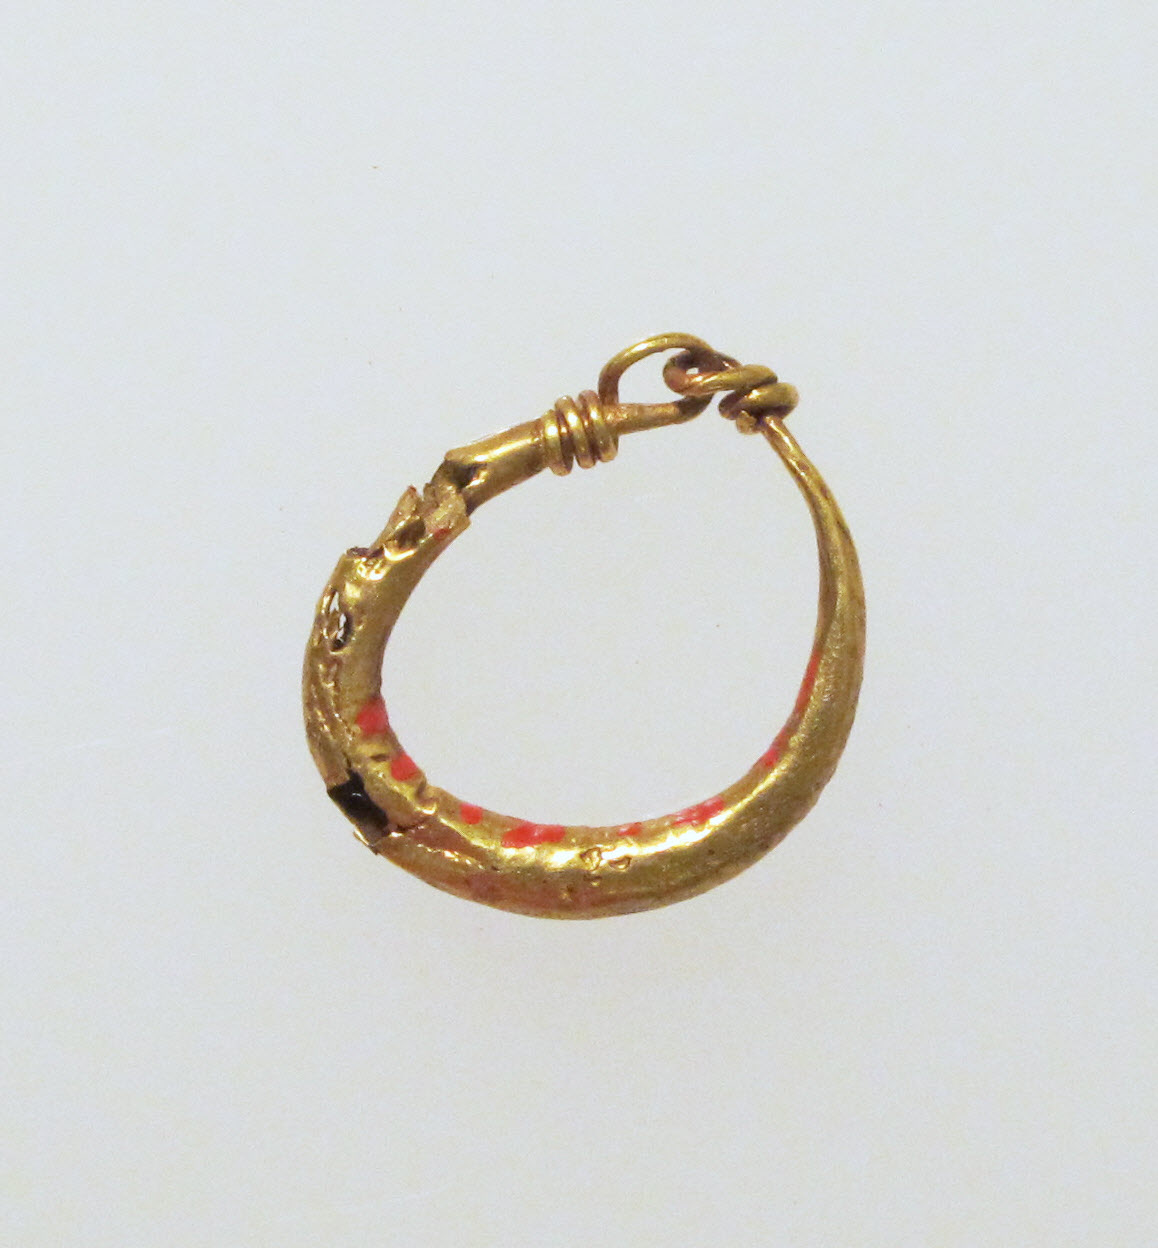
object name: earring loop type, plain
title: Earring-loop type, plain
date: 7000 BCE-330 CE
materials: gold